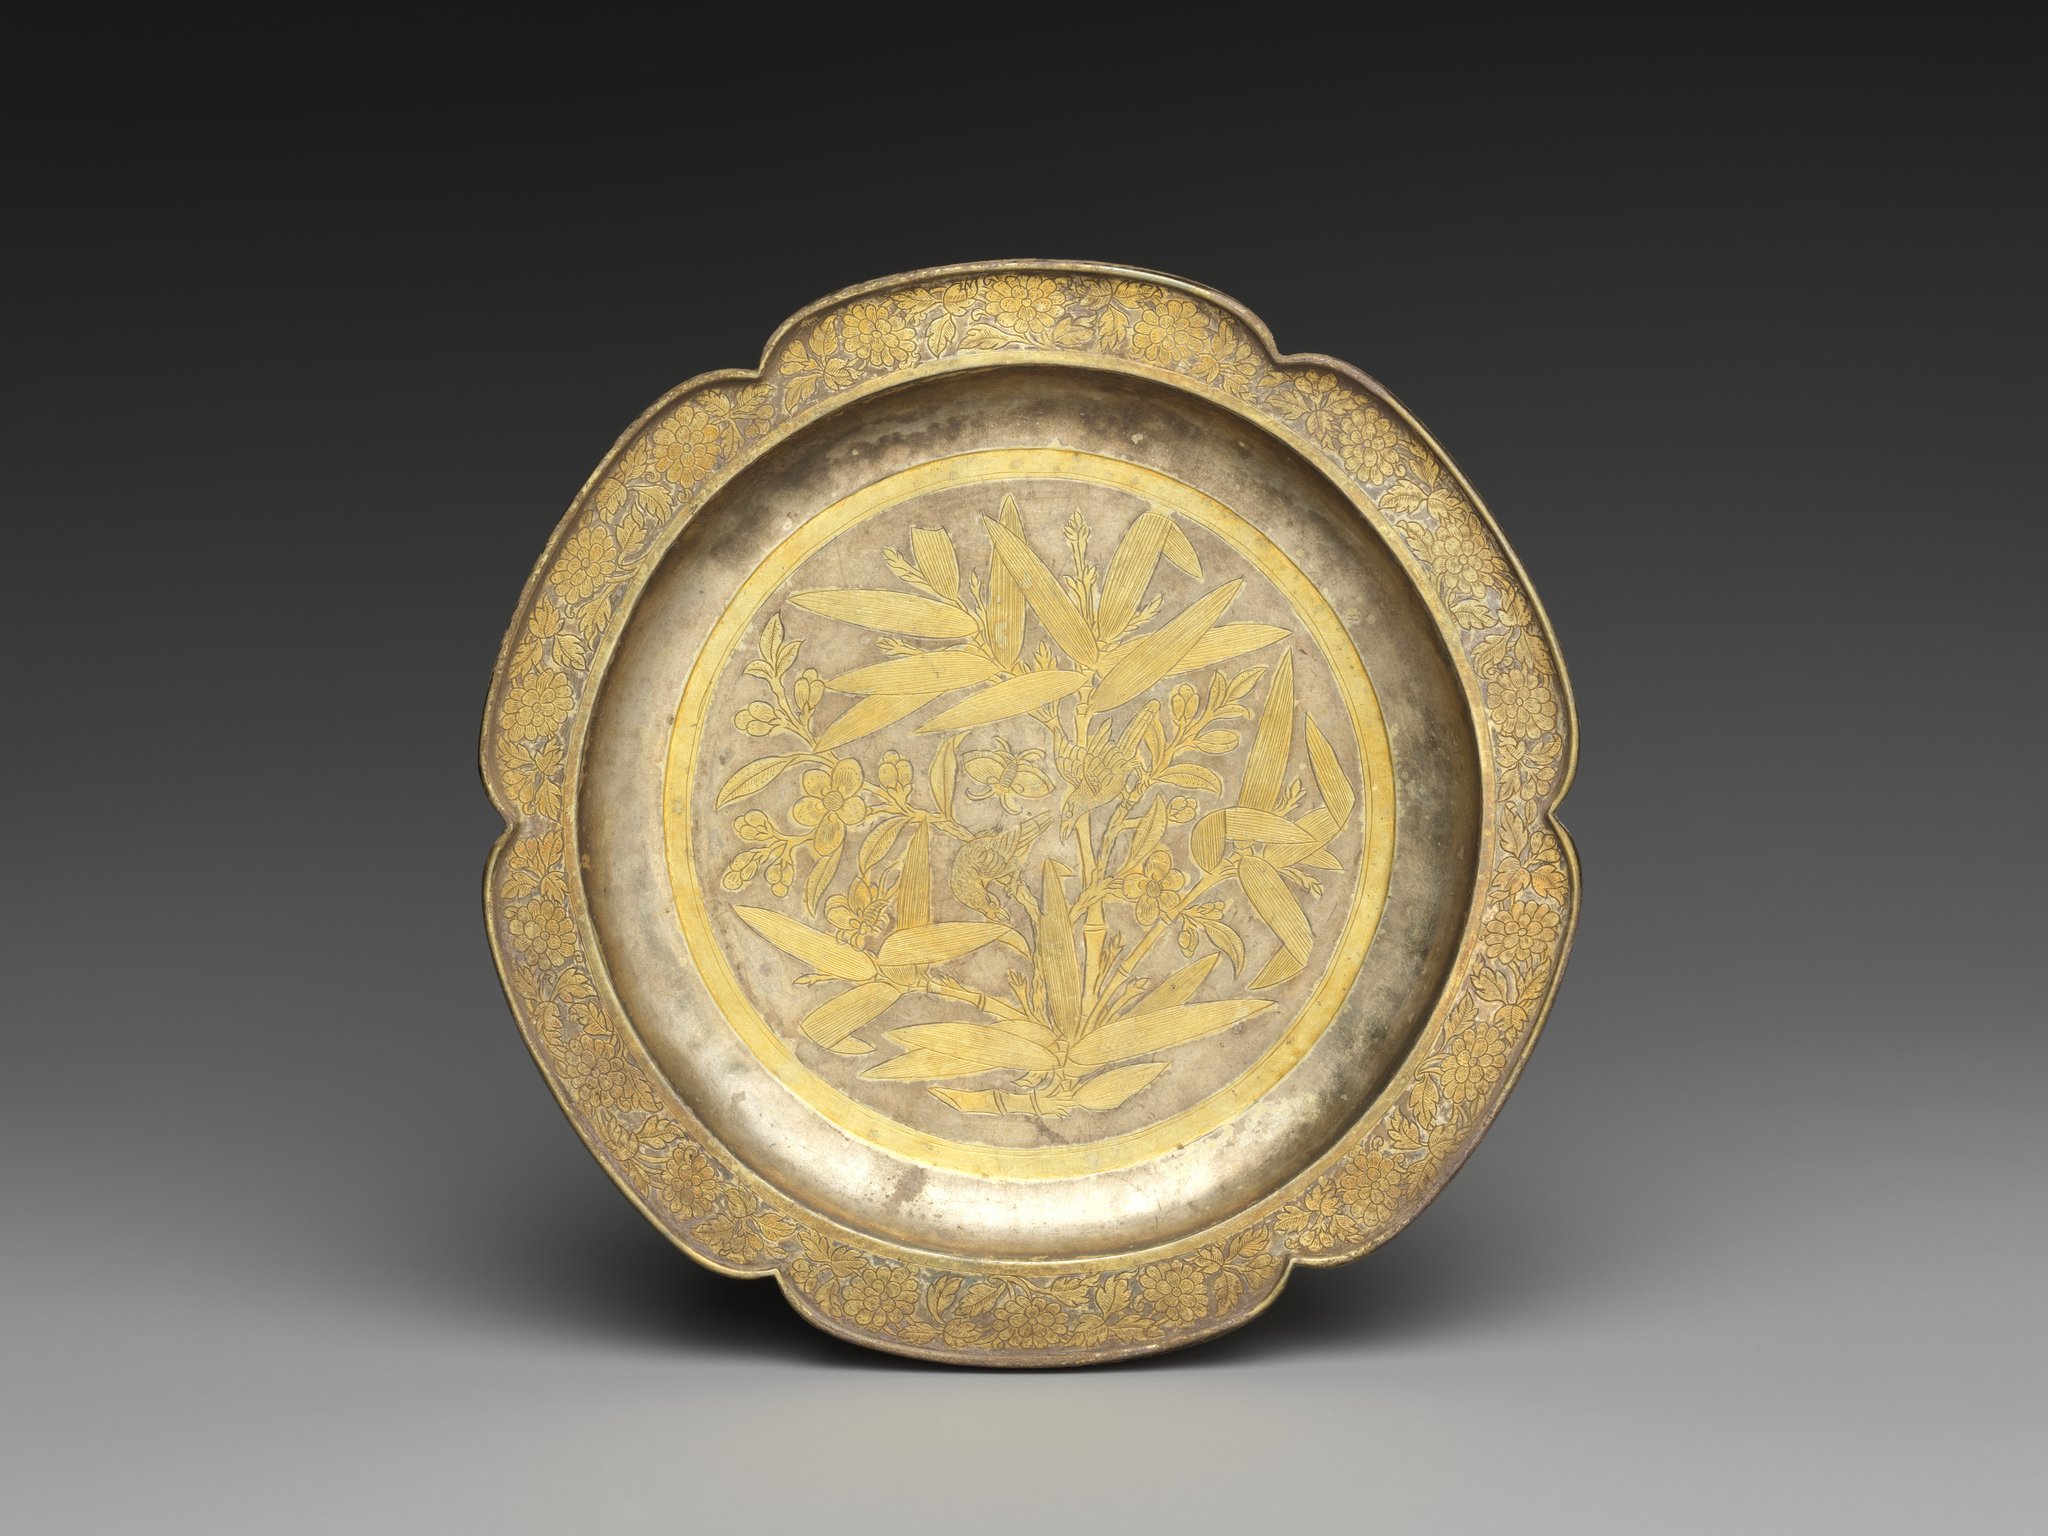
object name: dish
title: Lobed dish with flowers and birds (one from a set)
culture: chinese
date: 1267-1400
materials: silver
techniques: chasing, gilding